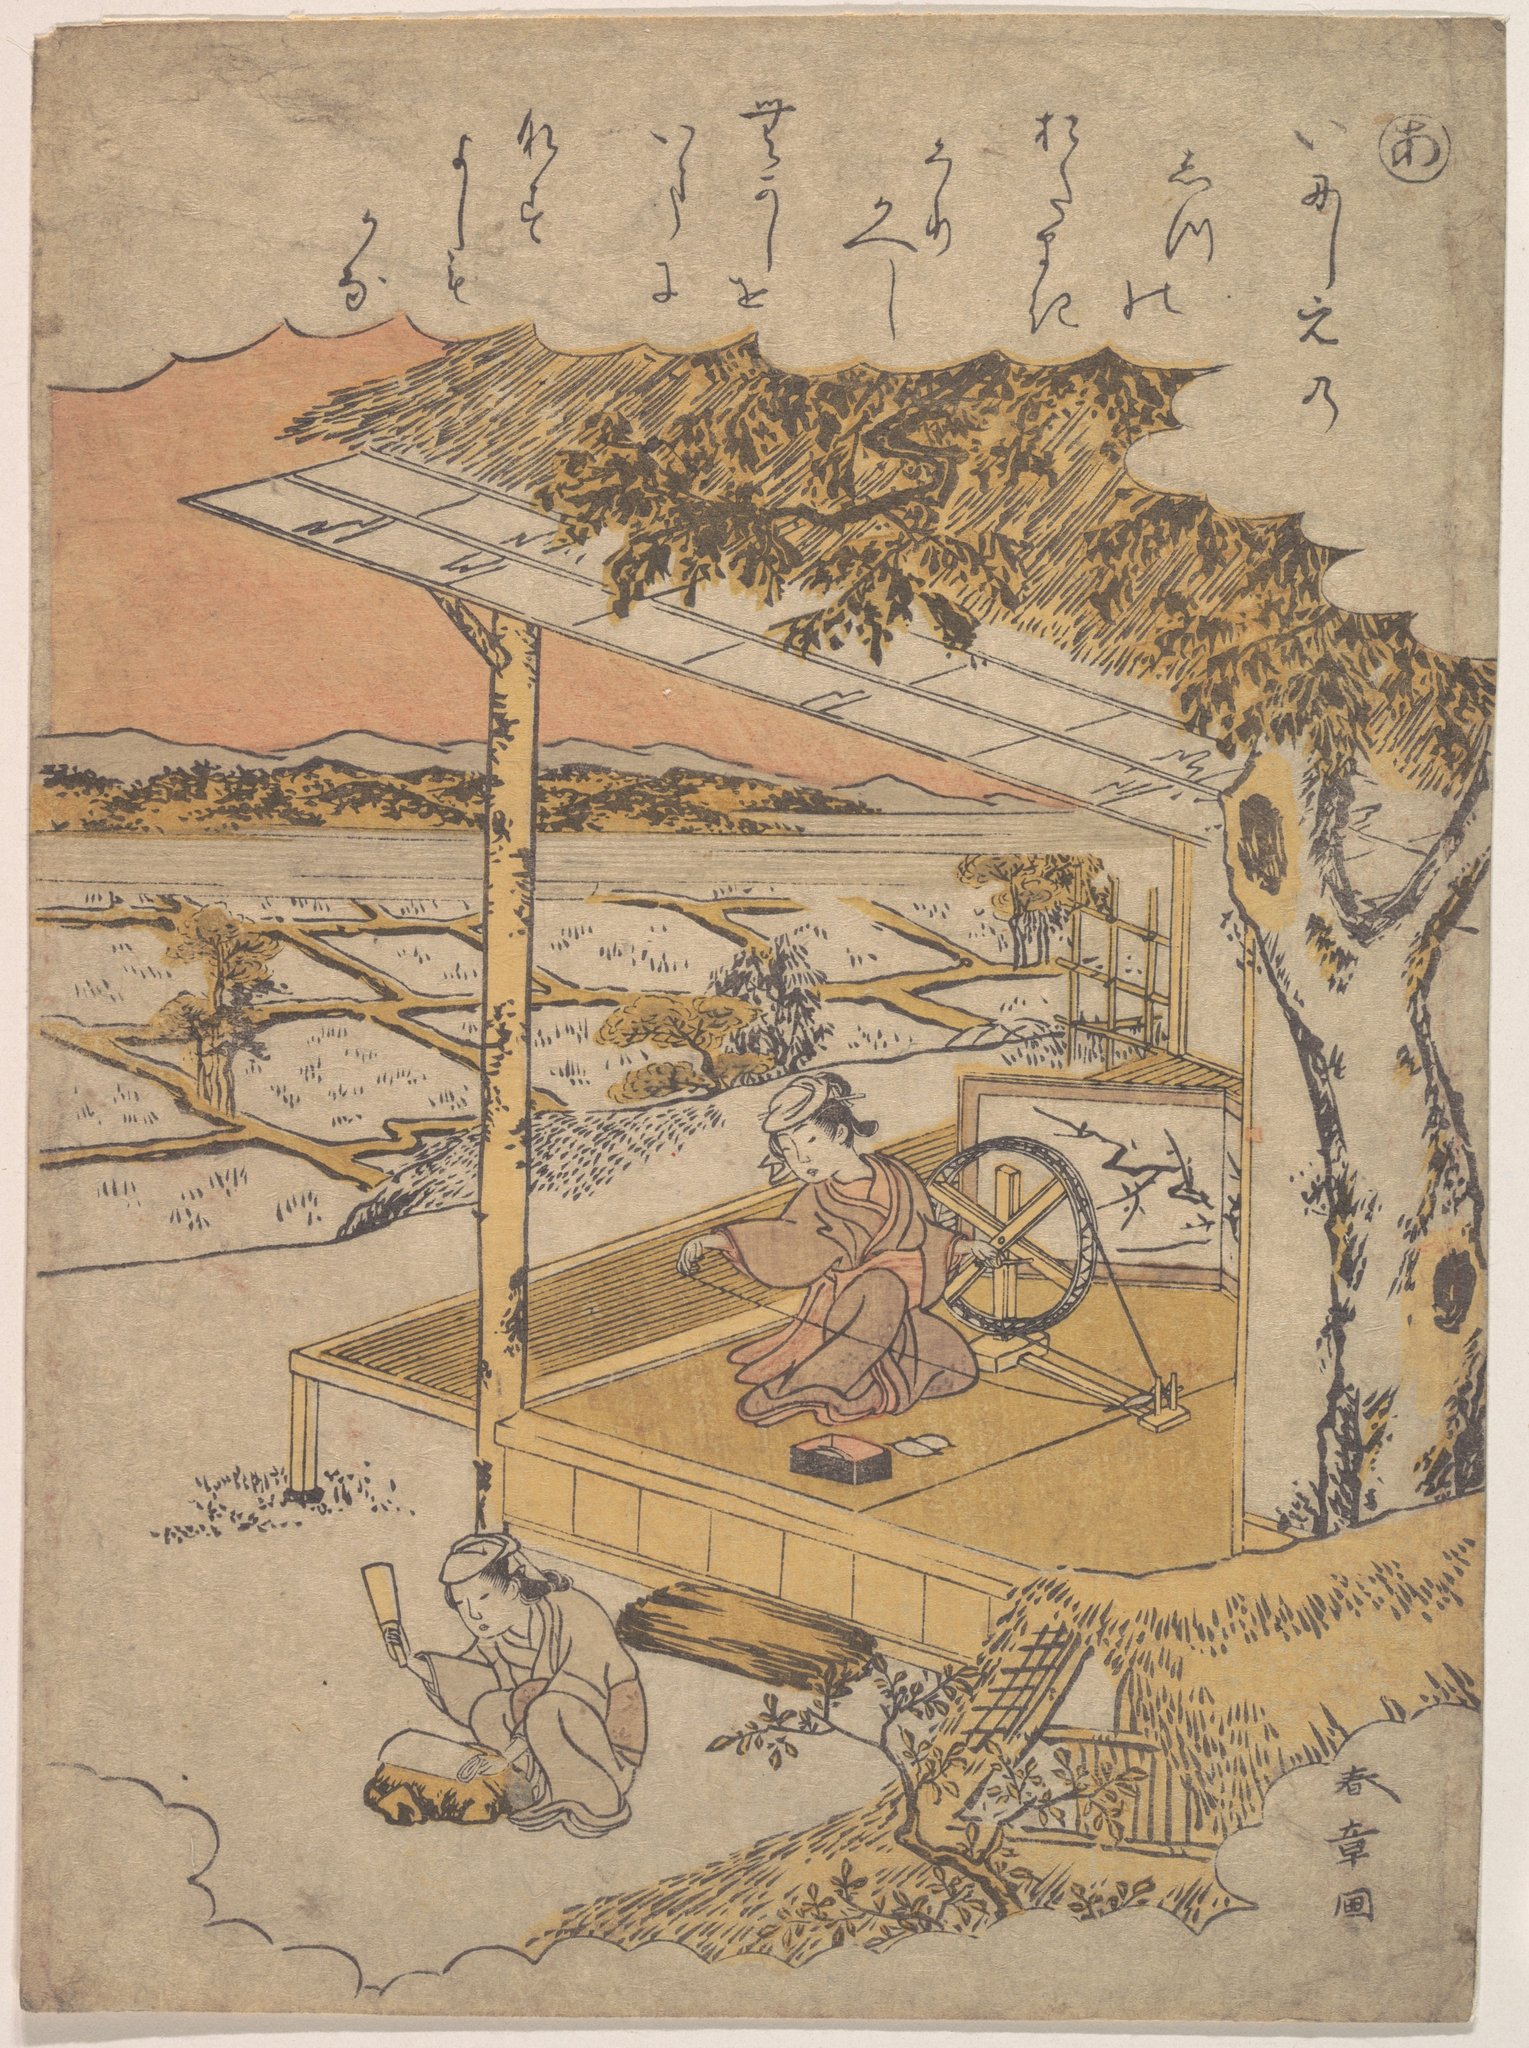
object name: woodblock print nishiki e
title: Woman on Veranda, Spinning; another Pounding Cloth on Rock in Foreground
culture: japanese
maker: katsukawa shunshō 勝川春章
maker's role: artist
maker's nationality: japanese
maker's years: 1726-1792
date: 1726-1792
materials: ink, paper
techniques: nishiki e, woodblock print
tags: women,trees,working